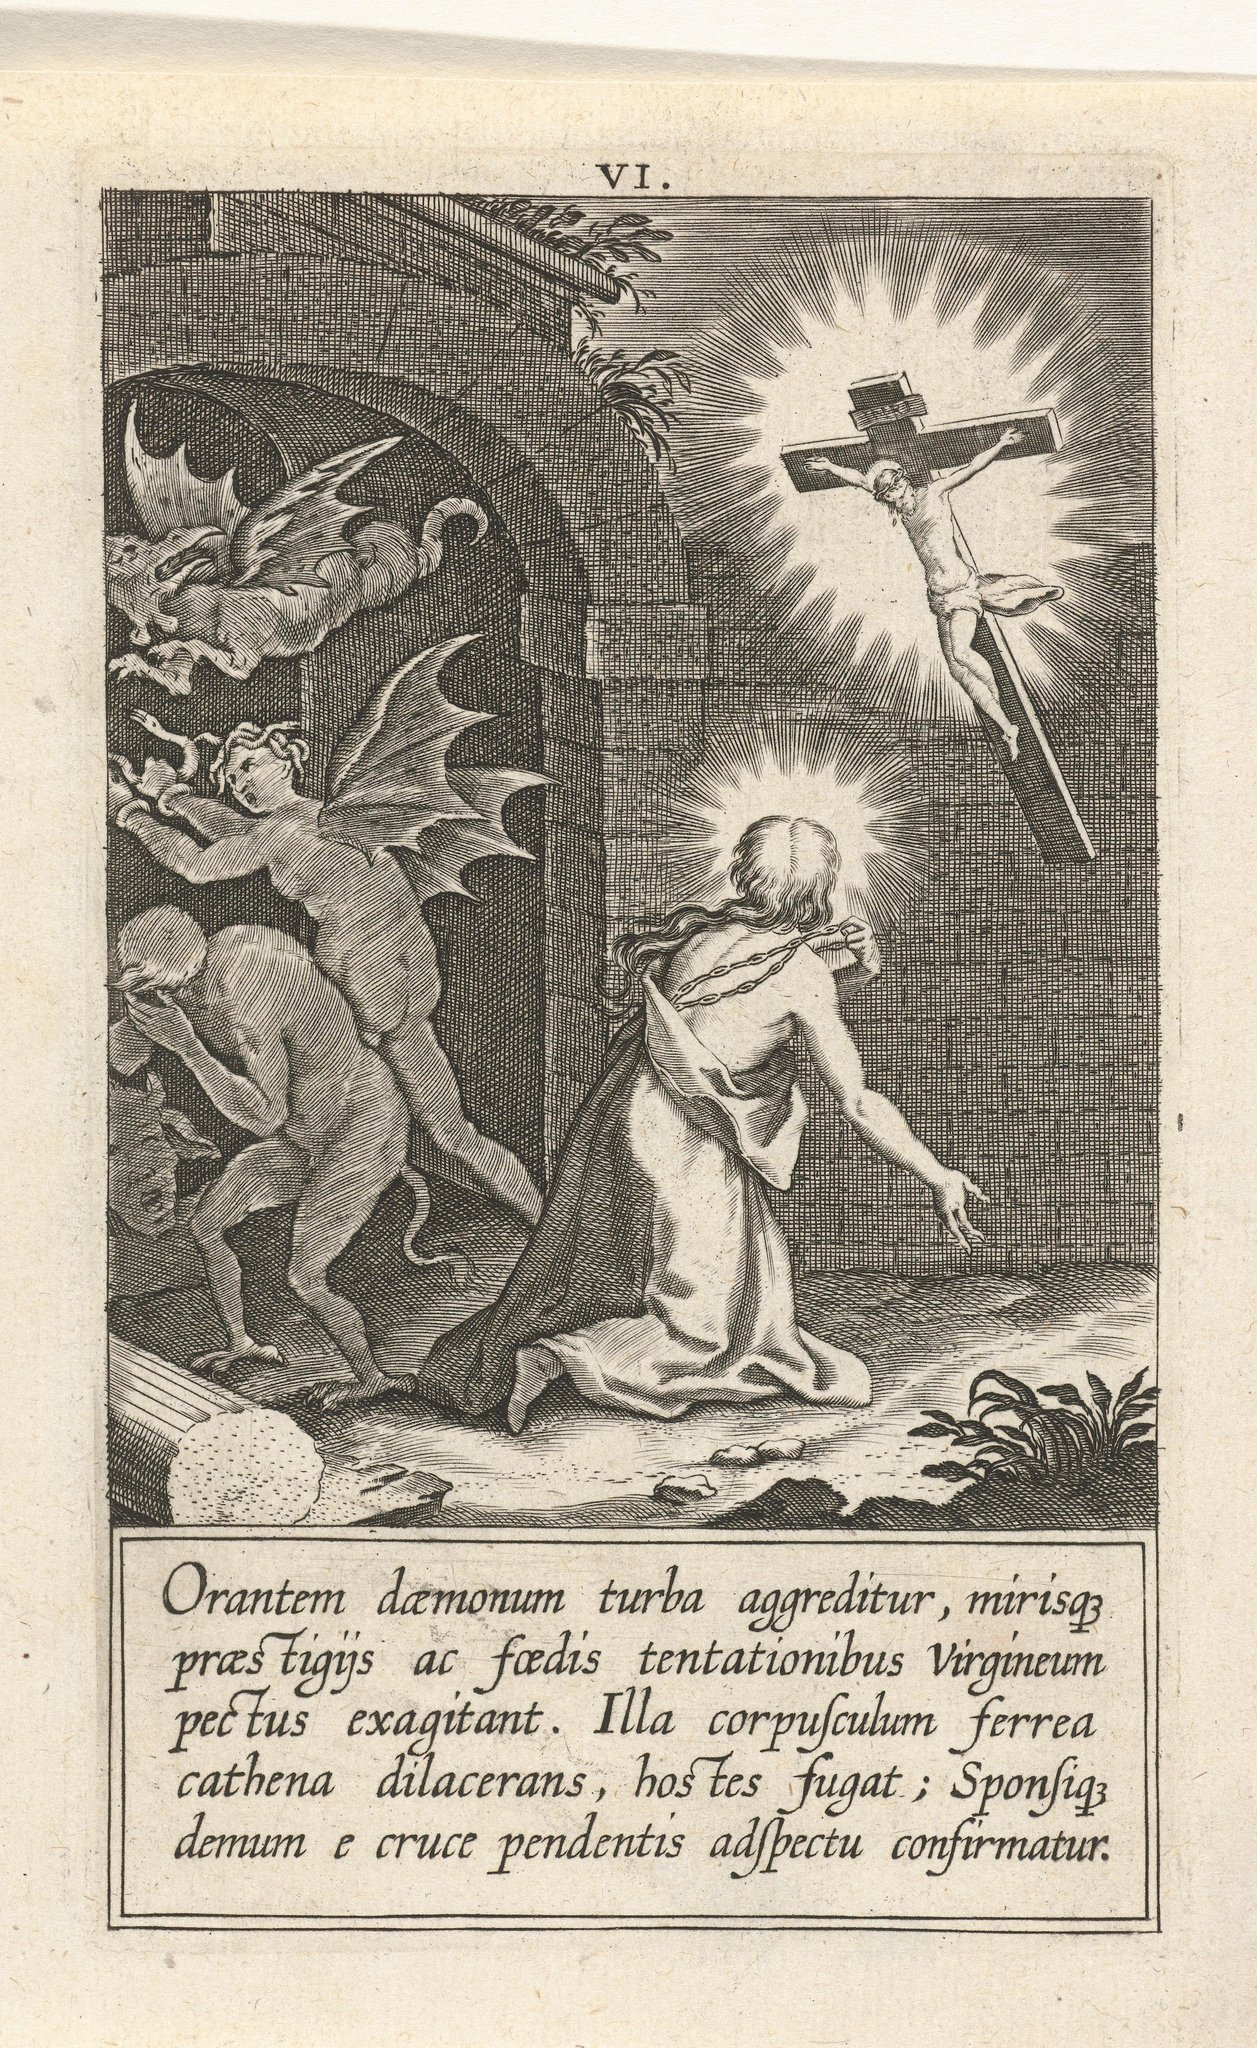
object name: print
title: Catharina heeft een visioen van een crucifix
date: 1603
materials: paper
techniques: engraving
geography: antwerp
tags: the virgin and dominican tertiary, catherine of siena; possible attributes: book, cross, crown of thorns, crucifix, demon under foot, heart (with cross), lily, plague-stricken, ring, rosary, stigmata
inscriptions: collector's mark: Lugt 2228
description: Catharina ziet een crucifix in een stralenkrans en kastijdt zich met een ketting die ze op haar blote rug slaat. Zo verslaat ze demonen die haar proberen te verleiden. De demonen, in de gedaante van naakte mannen met vleugels, vluchten door een stenen poort. Deel van een serie over Catharina van Siena bestaande uit een titelprent, een portret en 32 genummerde scènes uit haar leven.